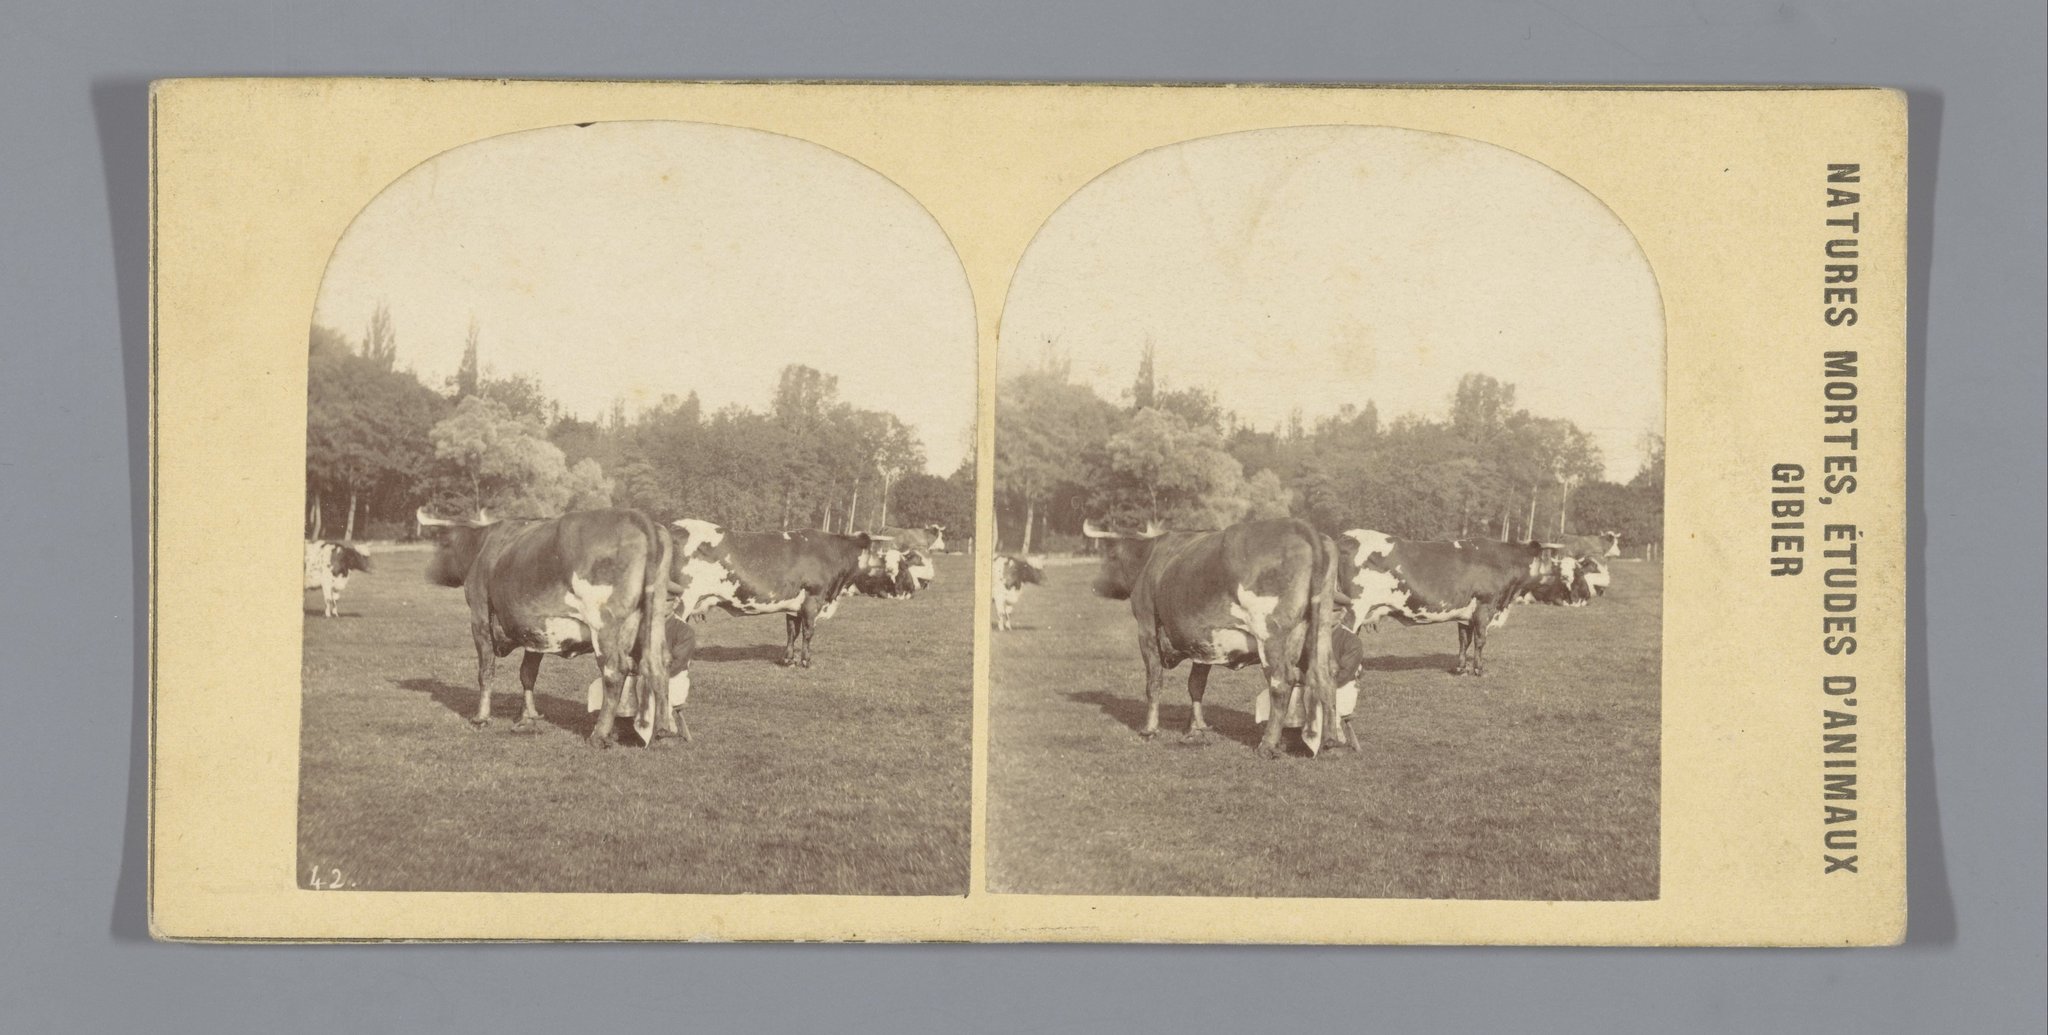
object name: stereograph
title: Natures mortes, études d'animaux gibier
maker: Anonymous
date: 1850-1880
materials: cardboard, photographic support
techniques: albumen print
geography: europe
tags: cow, europe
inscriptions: number: ‘4090 ig Ms 30’, number: ‘42.’